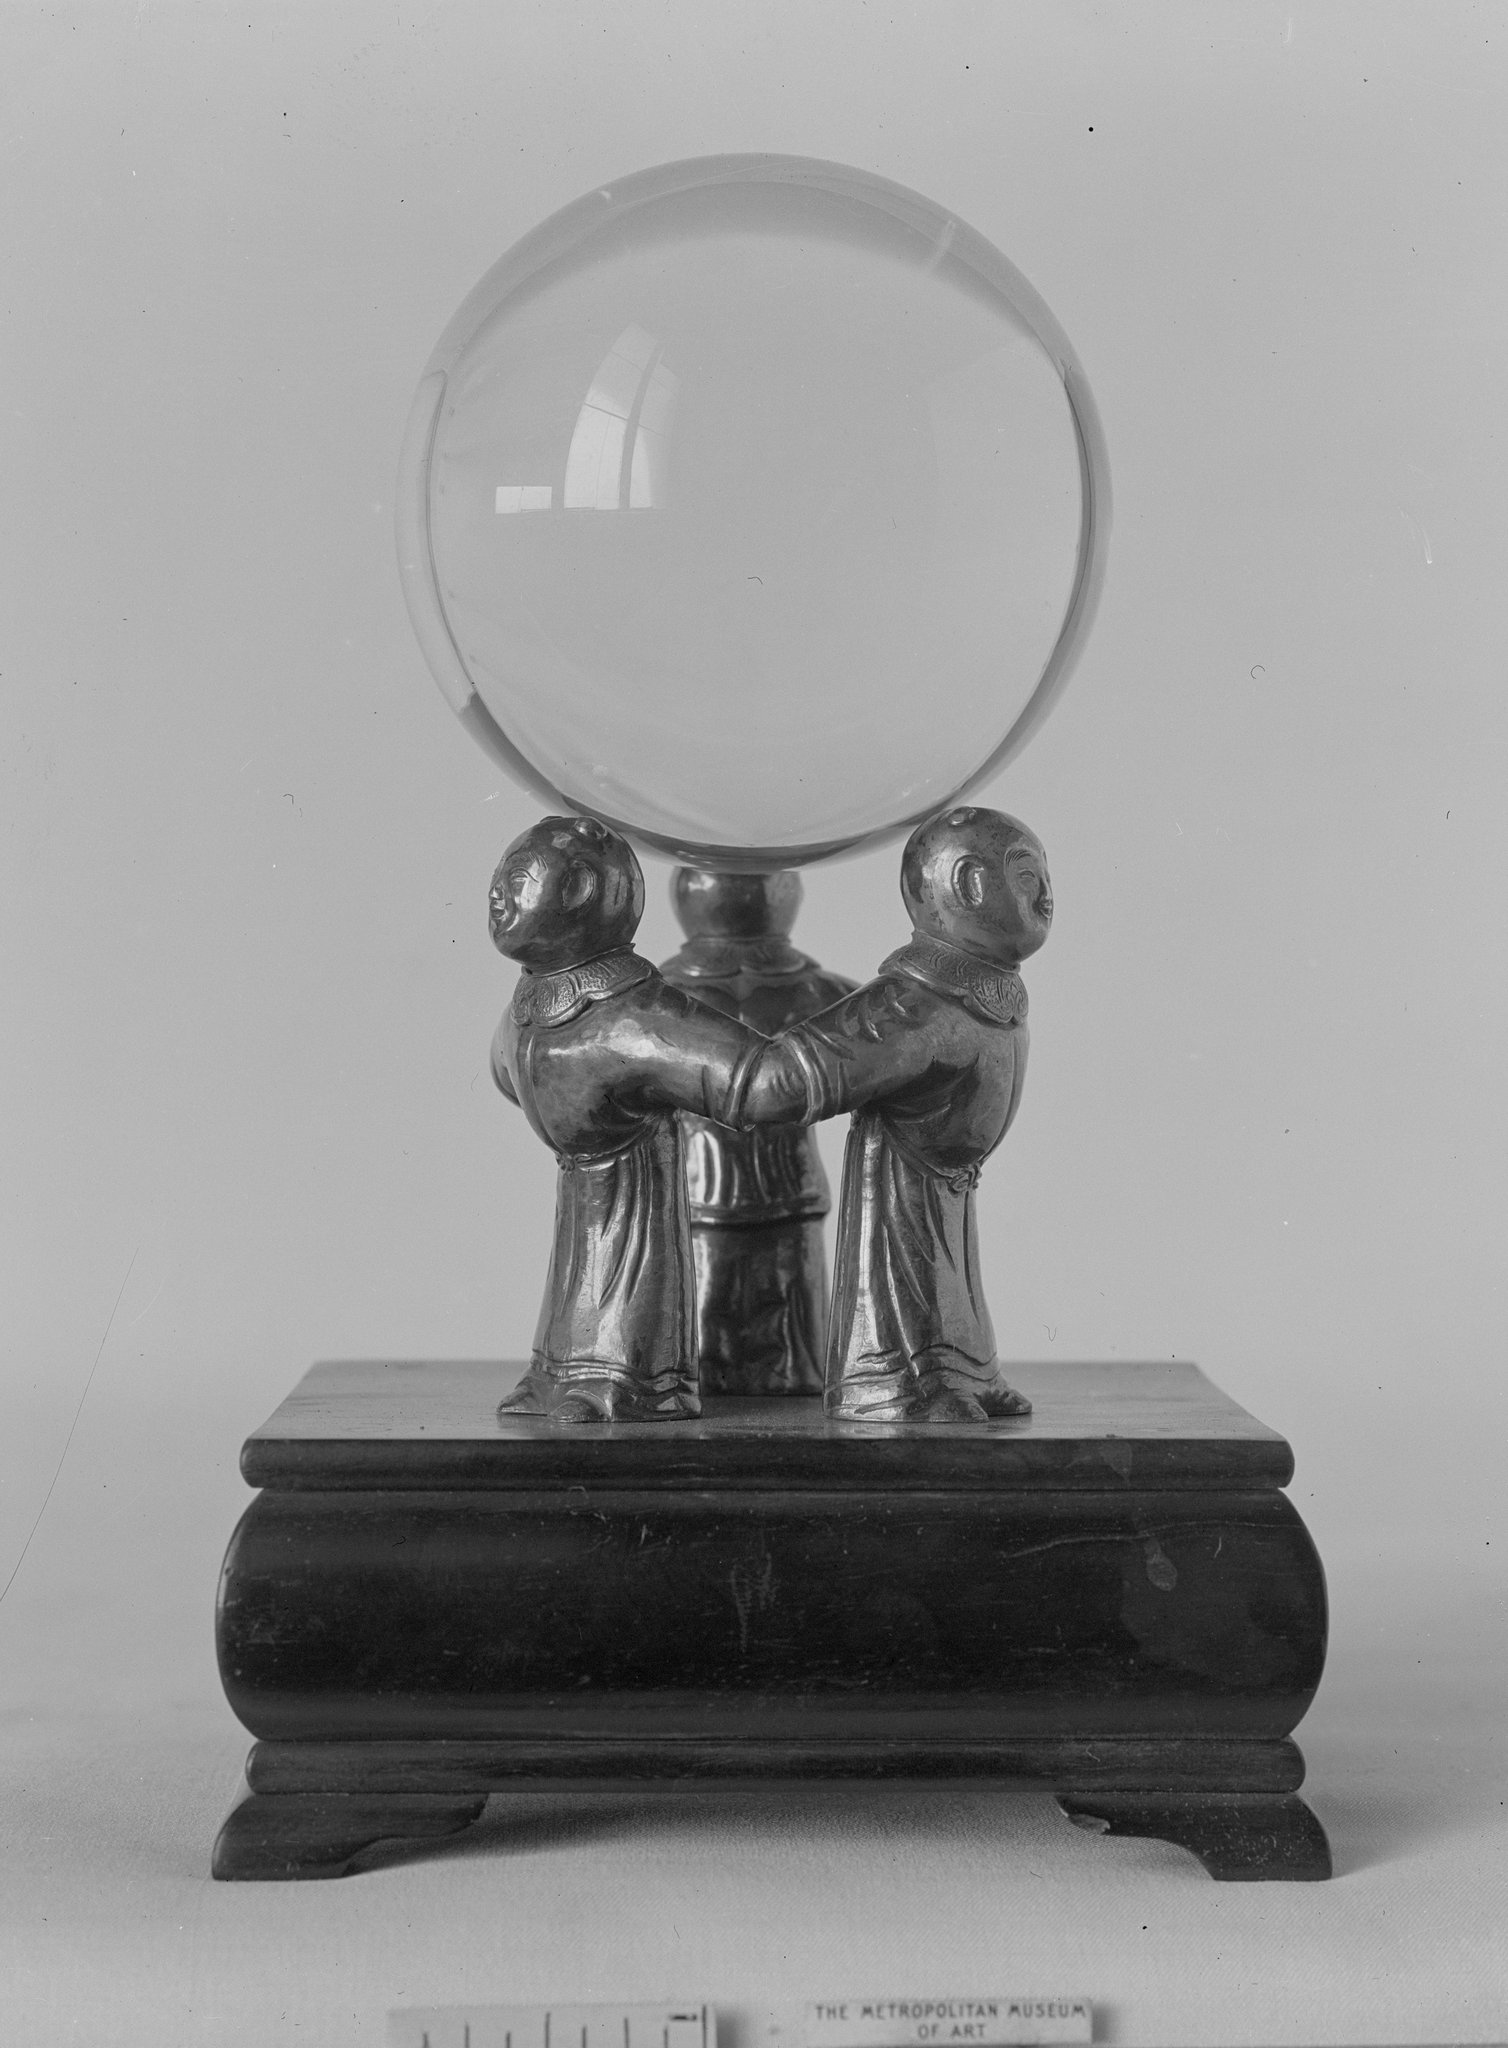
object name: crystal ball on stand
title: Crystal Ball on a Silver Stand composed of Three Figures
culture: chinese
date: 1701-1800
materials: quartz, silver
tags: men